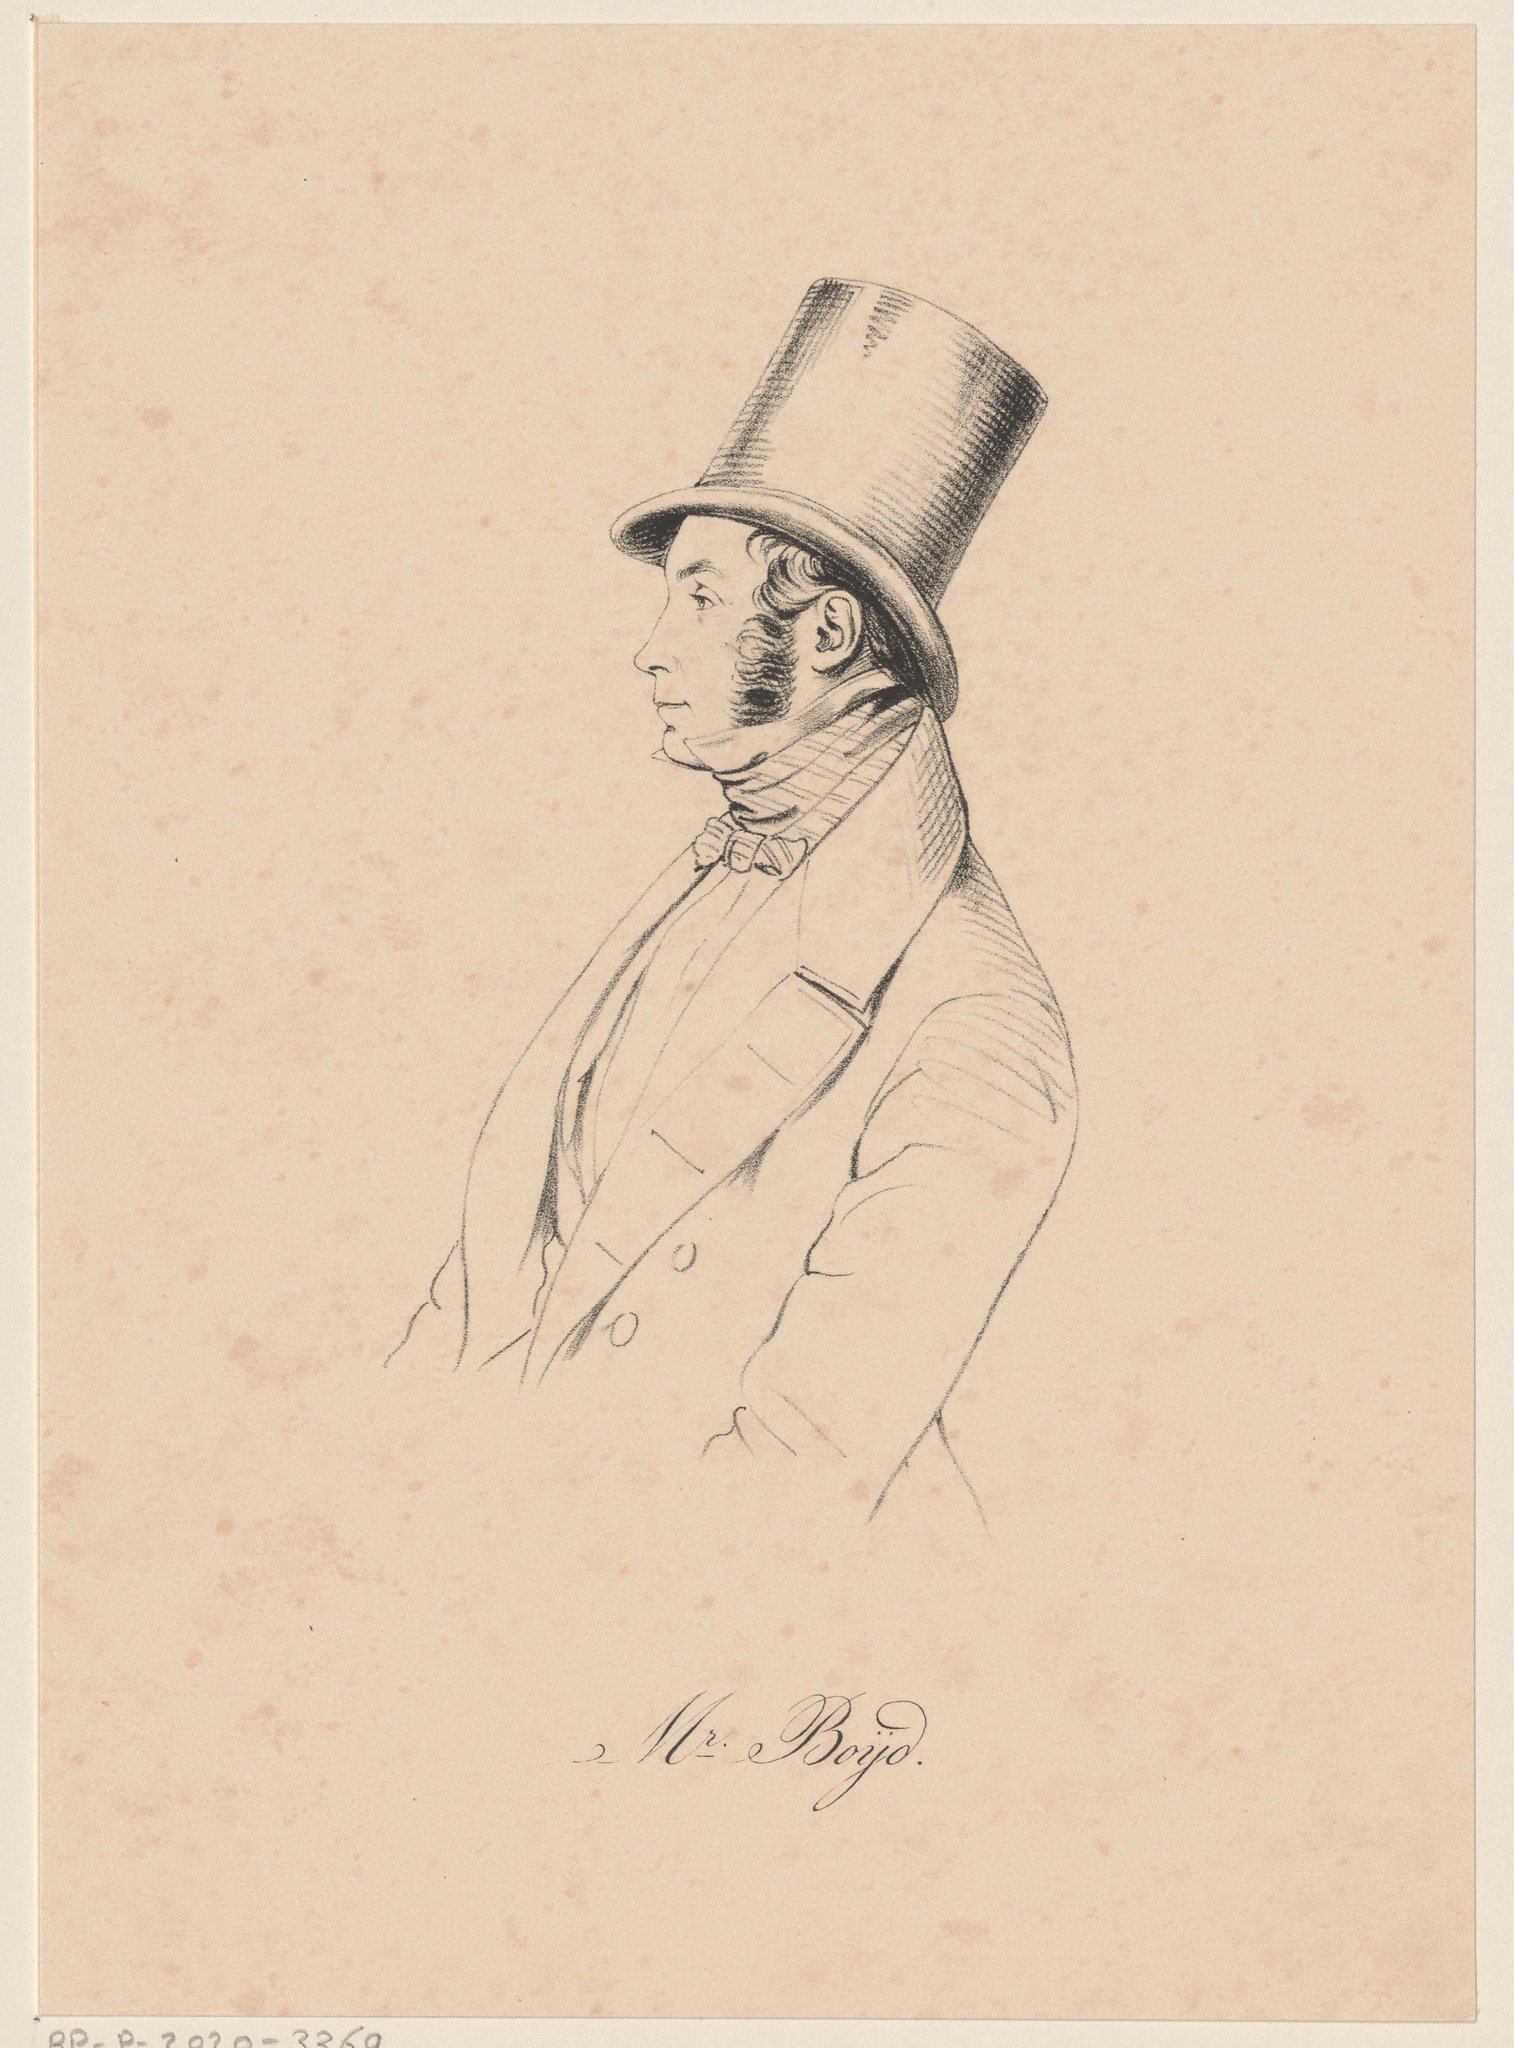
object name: print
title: Portret van mogelijk William Boyd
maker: alfred guillaume gabriel d orsay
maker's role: print maker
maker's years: 1801-1852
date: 1811-1852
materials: paper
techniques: lithograph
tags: historical persons, head-gear: hat